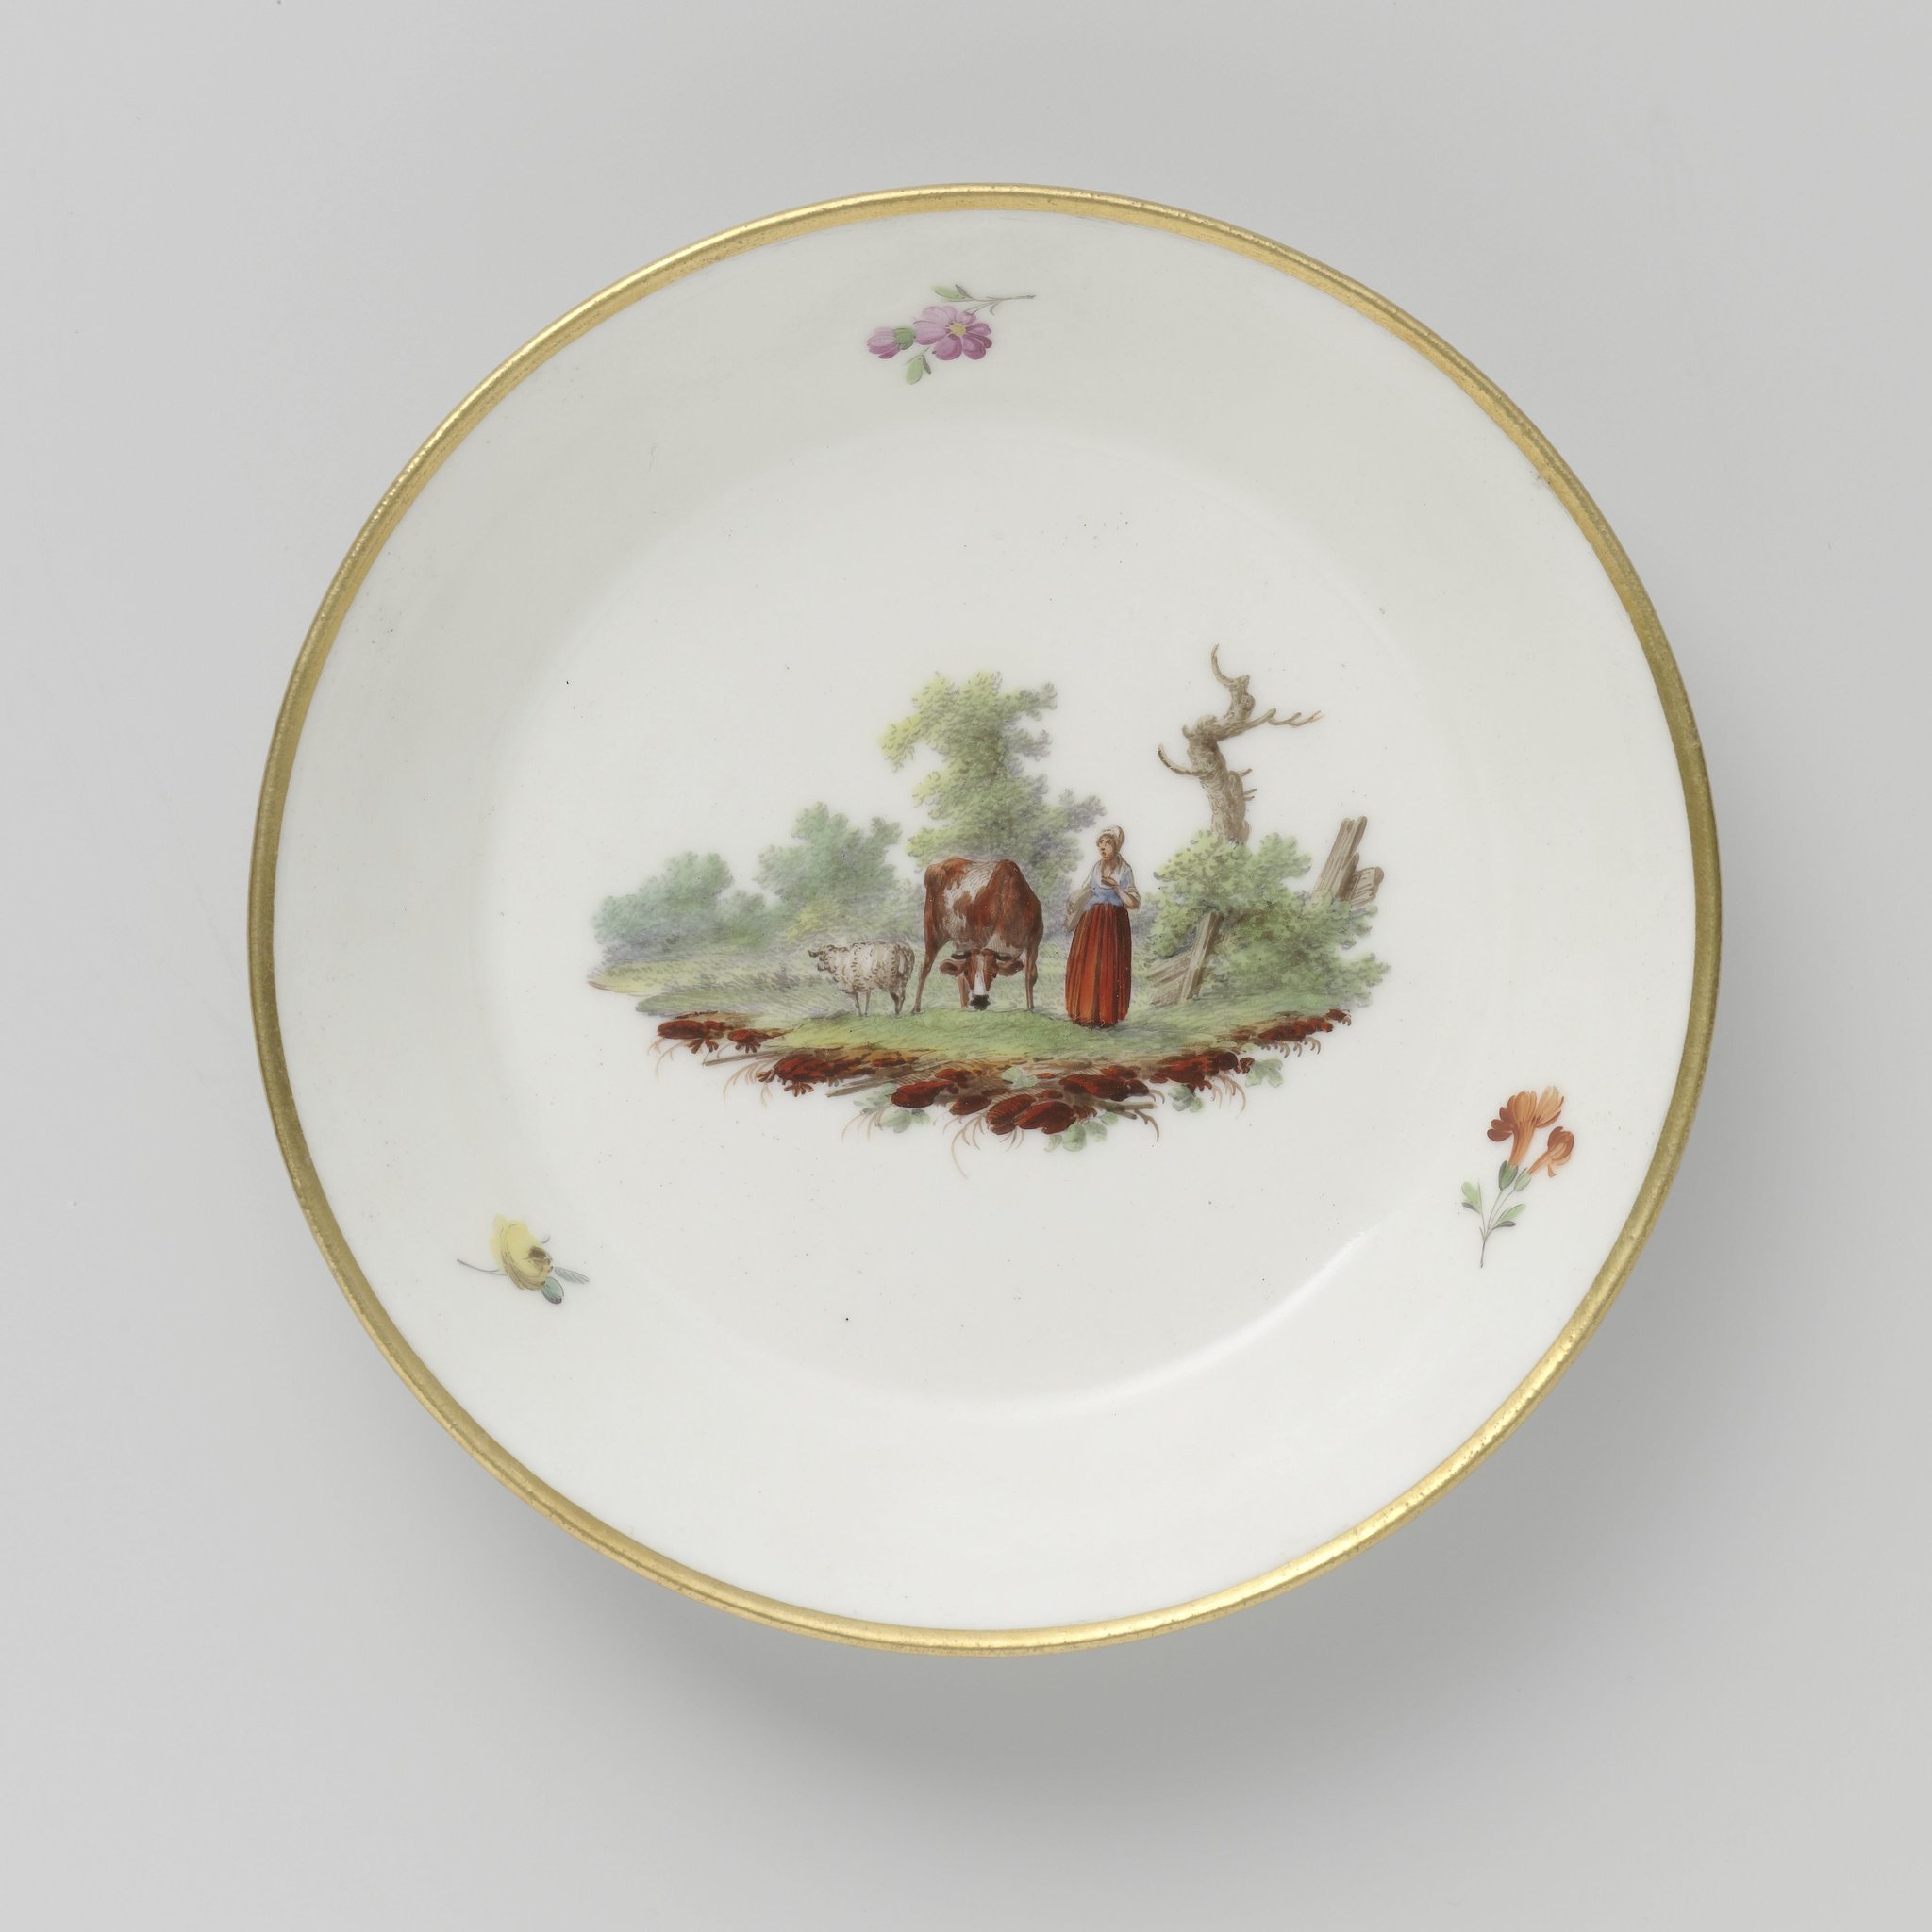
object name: platter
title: Schotel, beschilderd met een landschap met vee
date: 1809-1814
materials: porcelain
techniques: painted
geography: nieuwer-amstel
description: Schotel, beschilderd met landschap met vee. Gemerkt: Amstel in blauw.